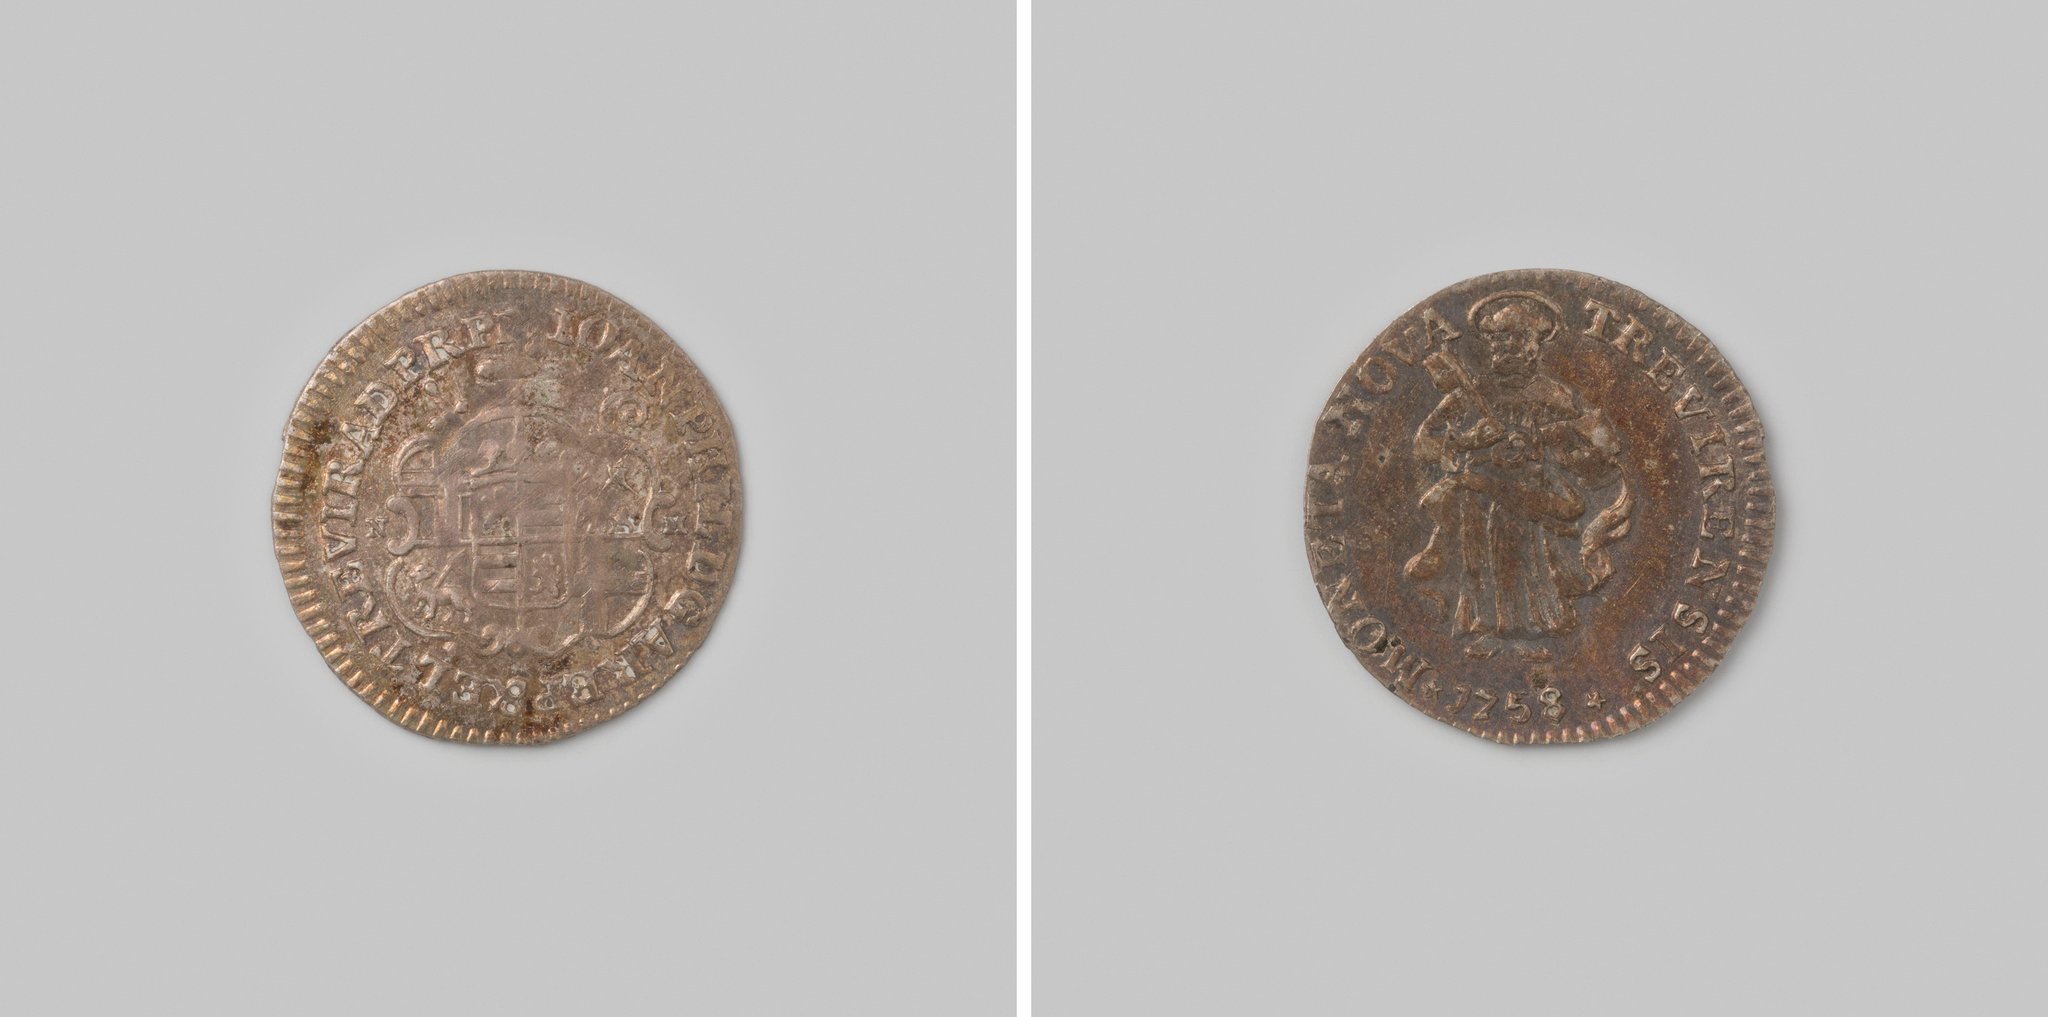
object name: coin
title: Bisdom Trier, Johann Philip, Petermenger, 1758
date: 1758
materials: silver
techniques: striking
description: Zilveren munt. Voorzijde: gekroond versierd wapenschild. Keerzijde: Sint Pieter met sleutel, staand. Jaartal onderaan in omschrift. Gladde rand.